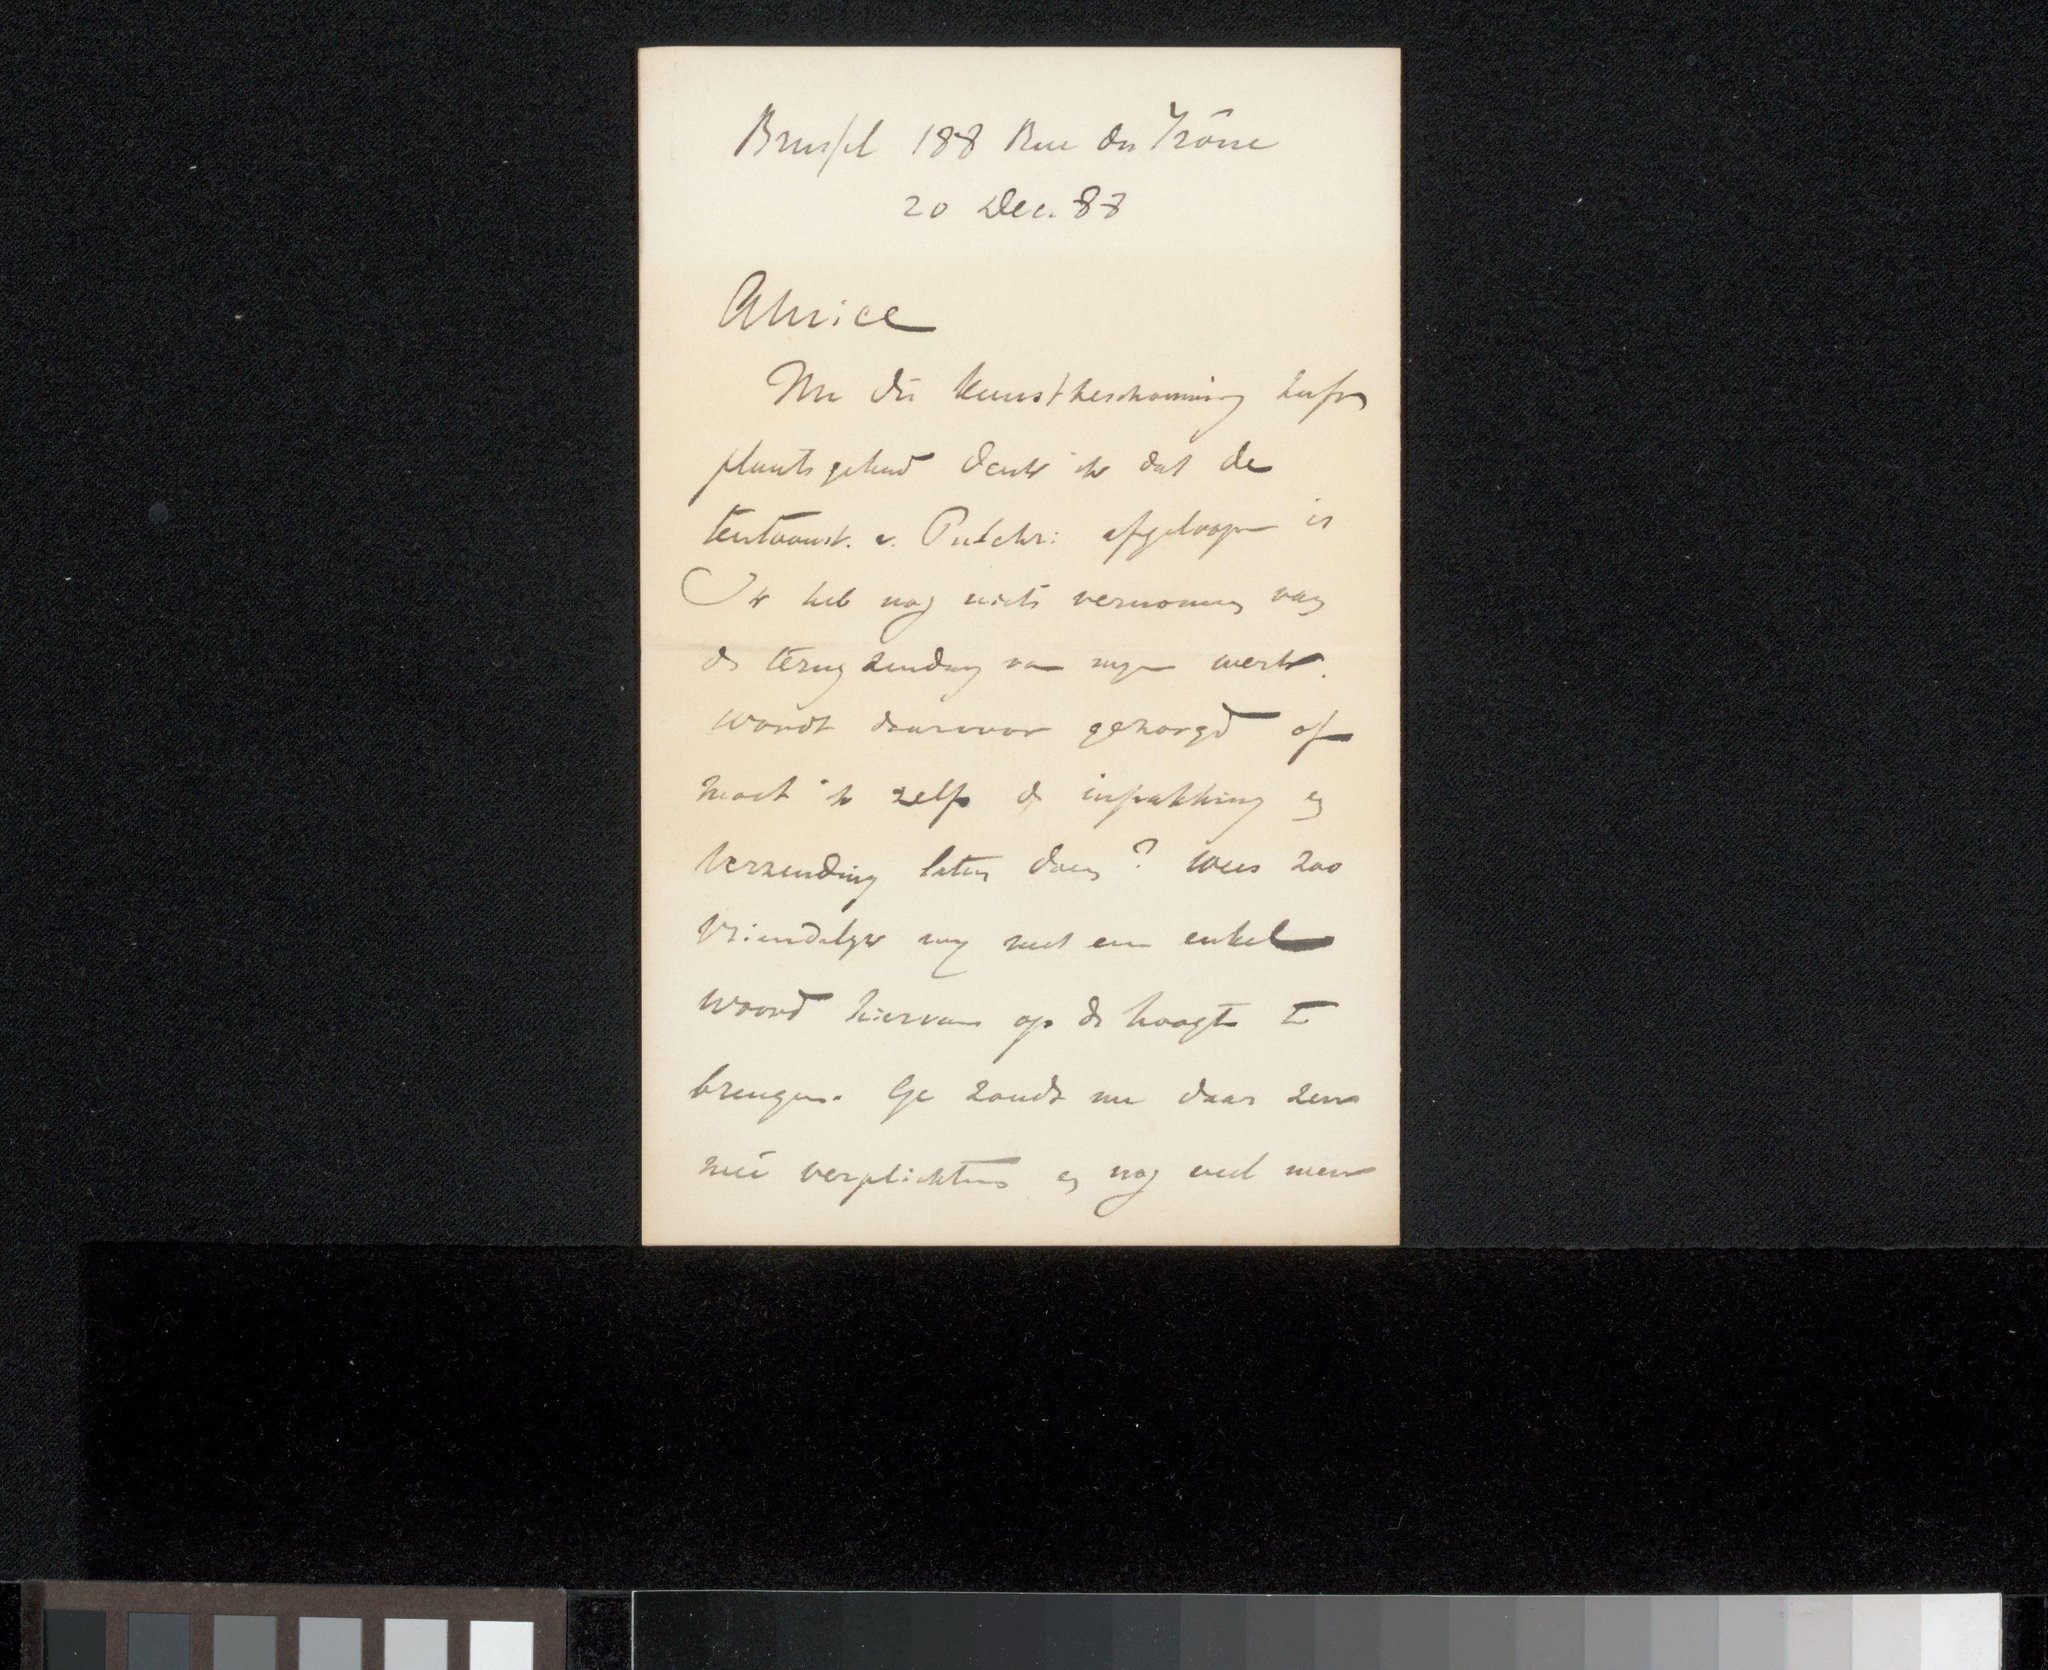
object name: letter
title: Brief aan Philip Zilcken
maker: carel nicolaas storm van s-gravesande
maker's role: draughtsman, print maker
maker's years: 1841-1924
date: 1887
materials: ink, paper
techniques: pen, writing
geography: brussels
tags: painter, philip zilcken, exhibition ~ art, the hague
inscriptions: watermark, collector's mark: ‘RPK’